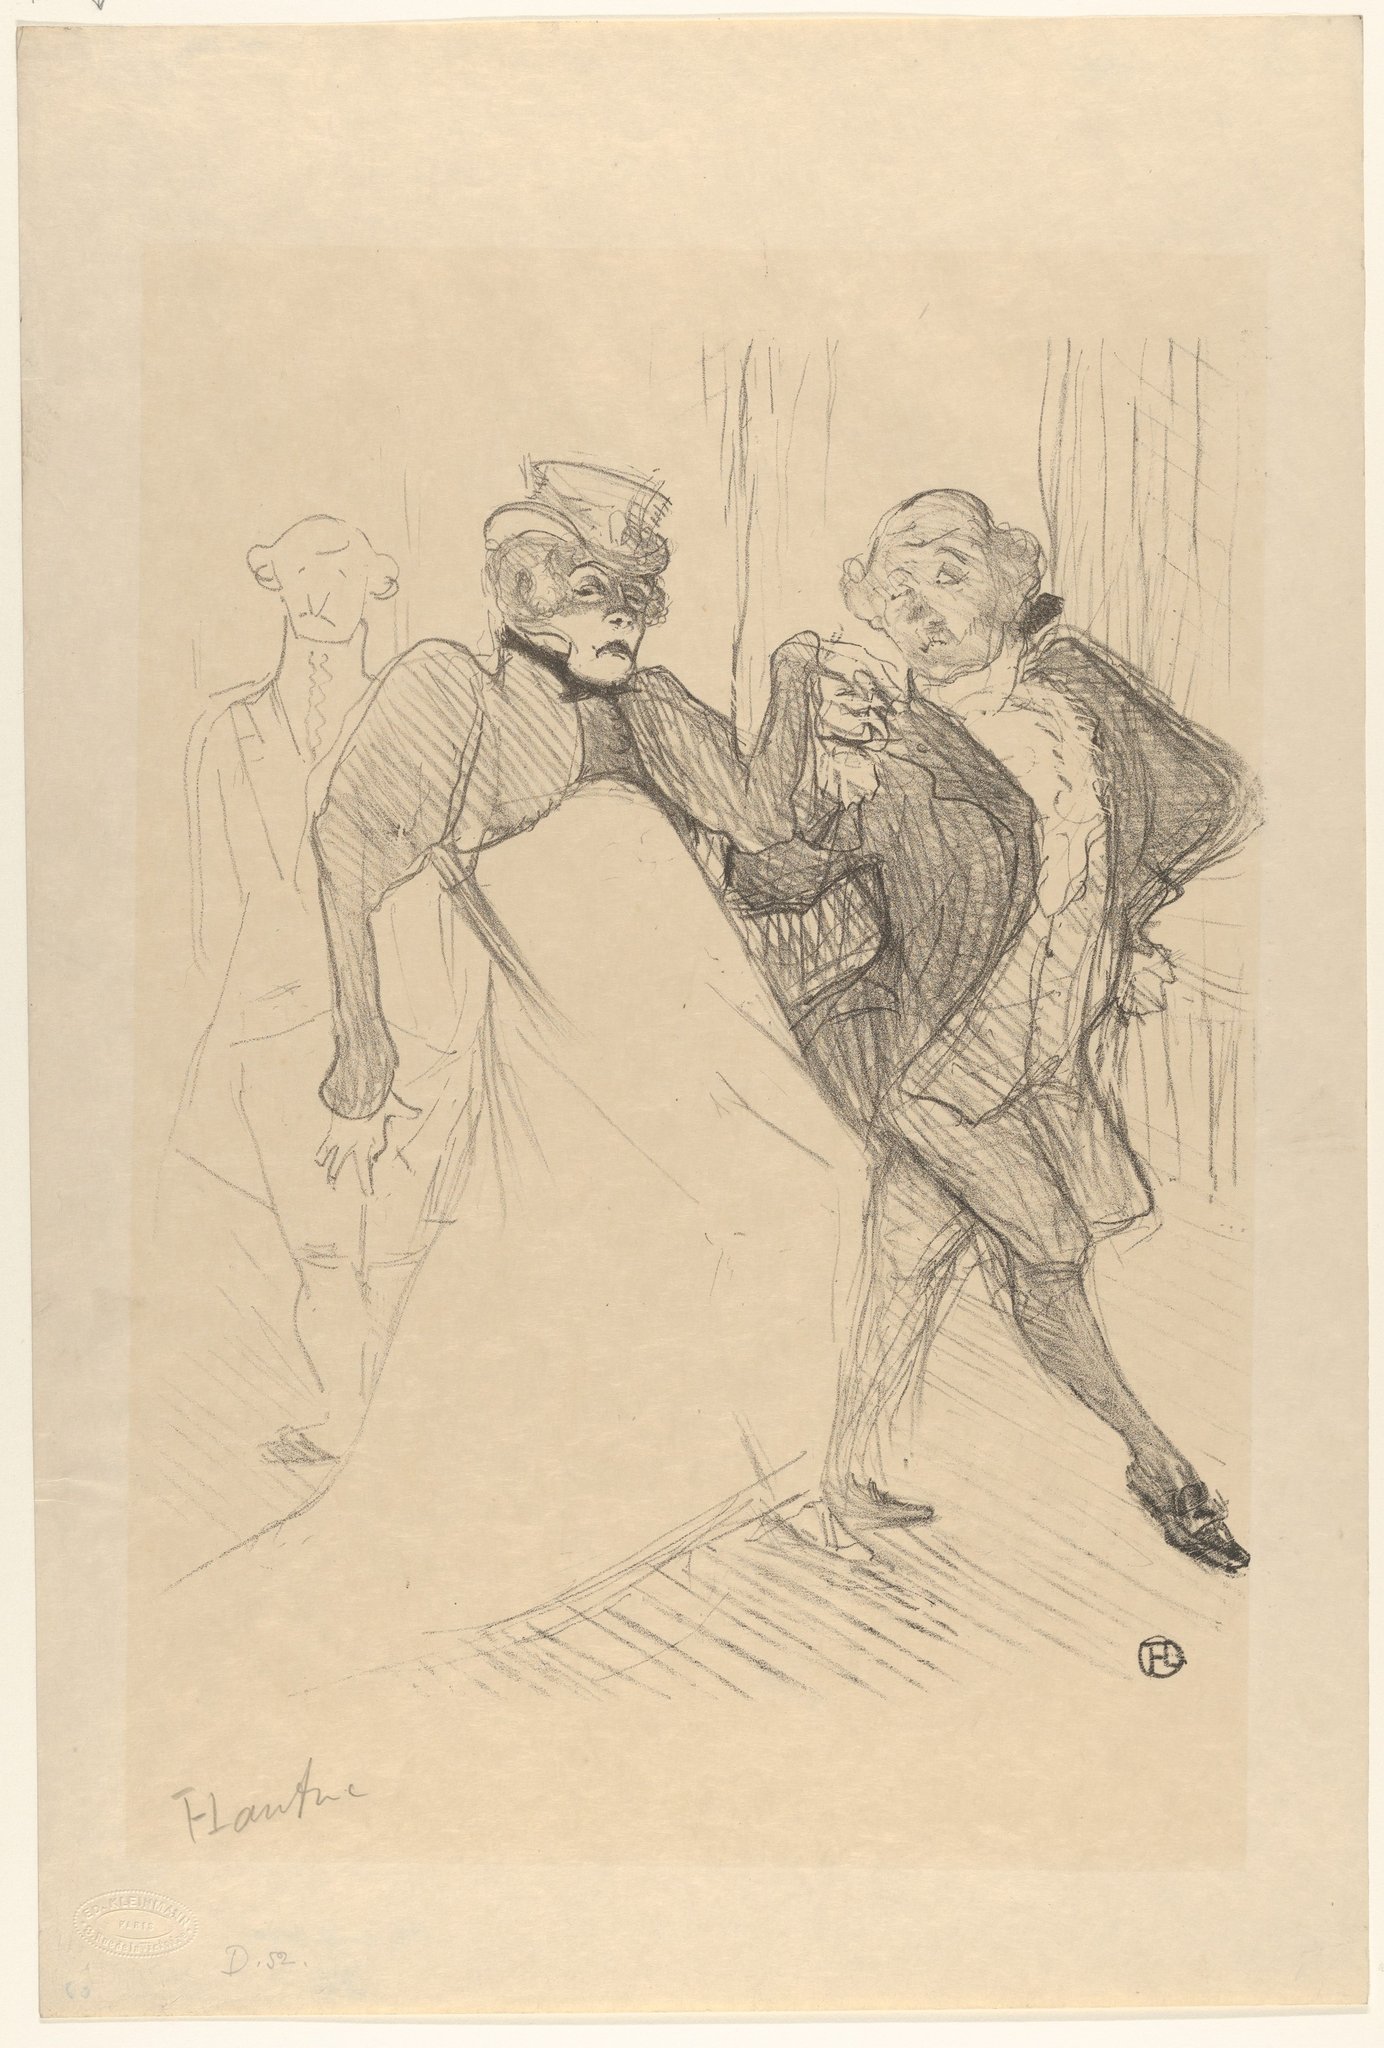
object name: print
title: Réjane and Galipaux, in Madame Sans-Géne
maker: henri de toulouse-lautrec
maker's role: artist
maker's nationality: french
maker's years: 1864-1901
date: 1893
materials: crayon, paper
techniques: lithograph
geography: france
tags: men,women,dancing